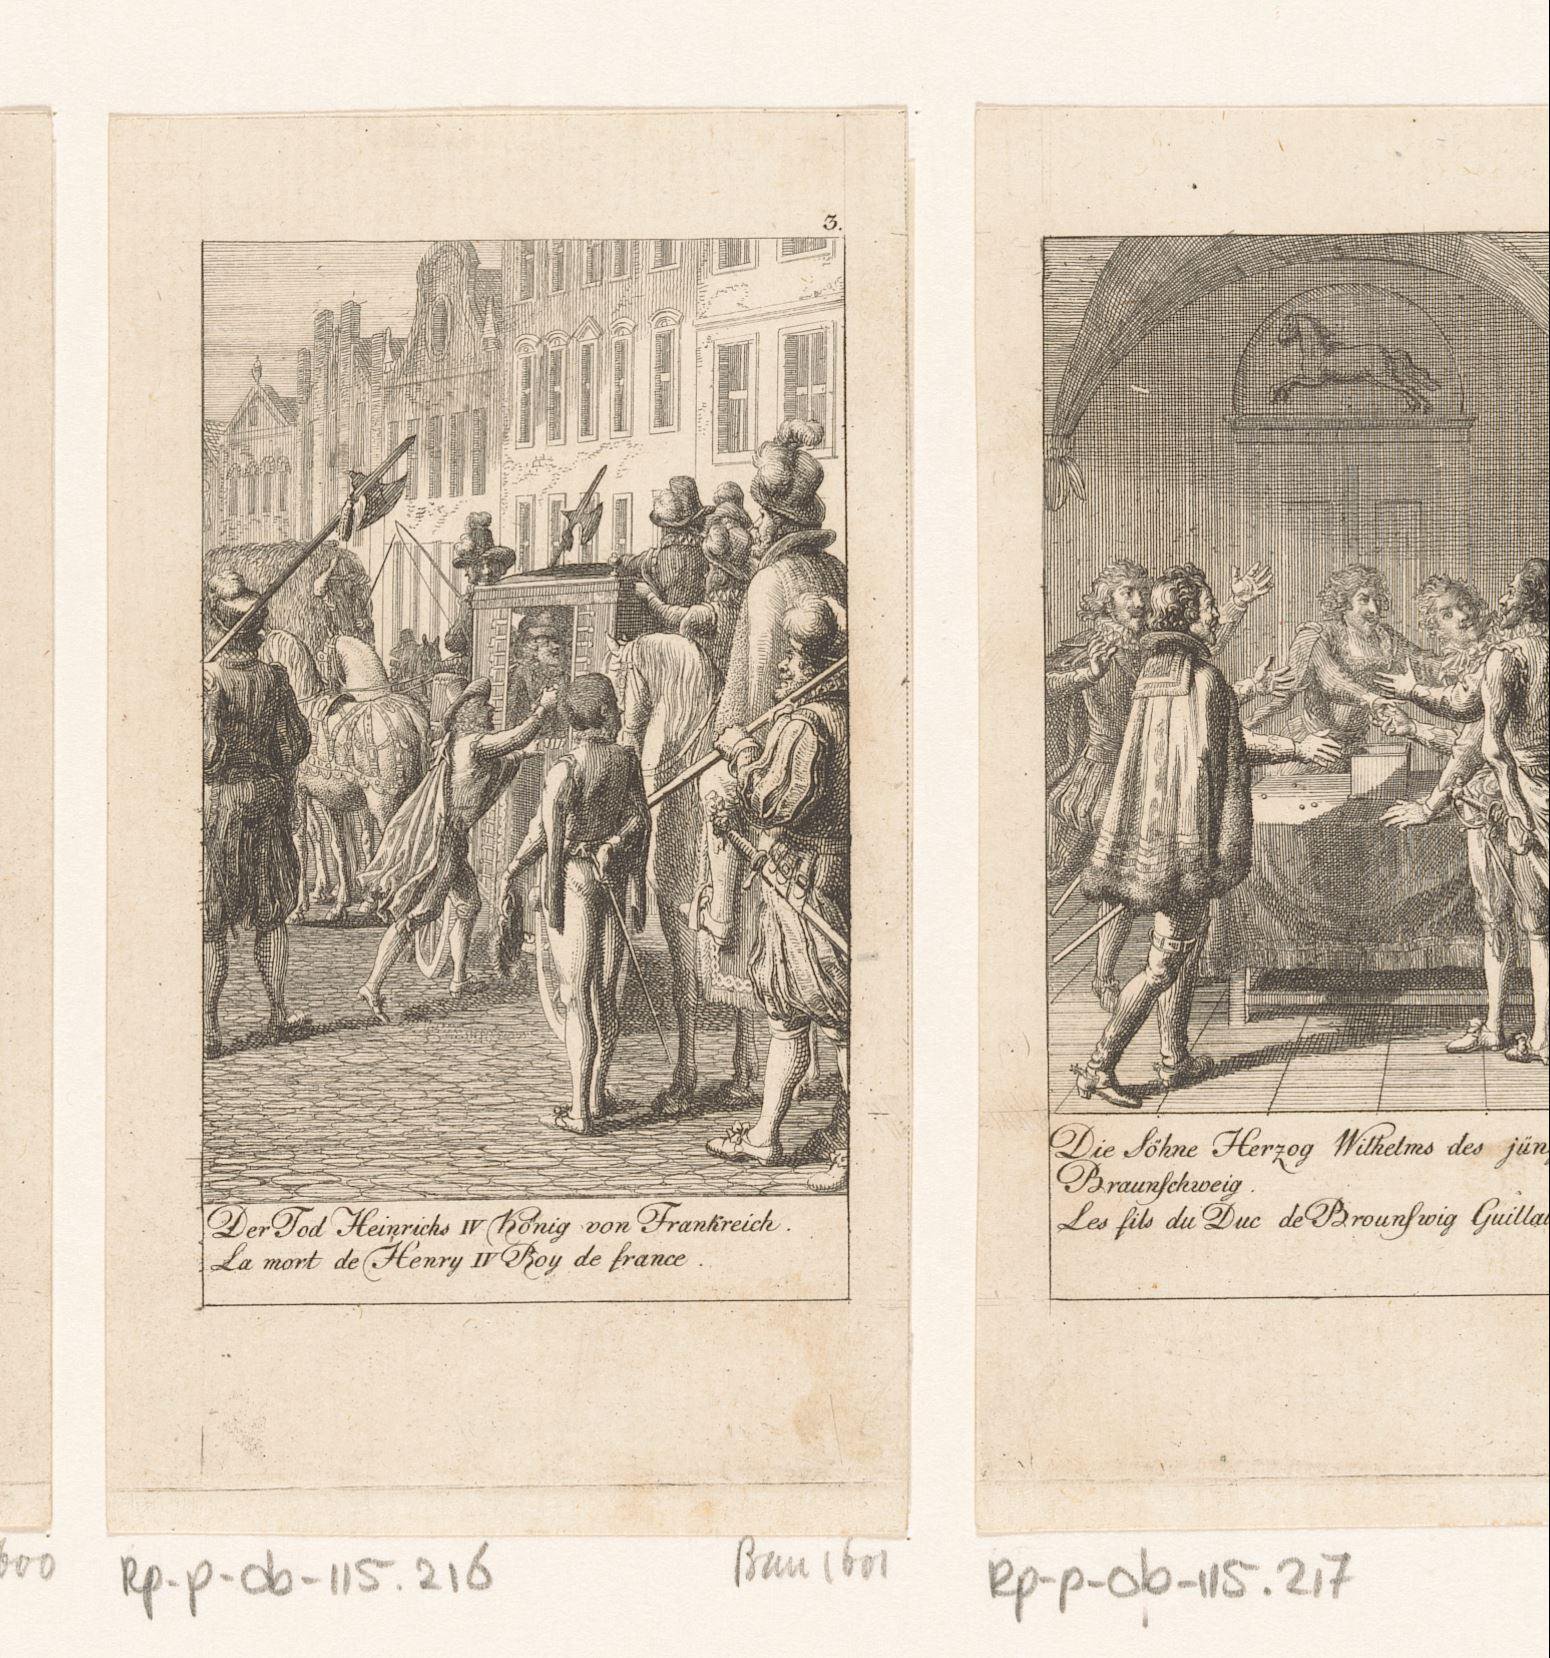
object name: print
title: Hendrik IV van Frankrijk wordt vermoord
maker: daniel nikolaus chodowiecki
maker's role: draughtsman, print maker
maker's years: 1726-1801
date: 1792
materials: paper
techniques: etching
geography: berlin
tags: paris, hendrik iv (koning van frankrijk en navarra), history, murder, ruler, sovereign, surprise attack (from ambush)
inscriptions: collector's mark: Lugt 2228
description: Latere staat gebruikt voor: Almanac de Gotha pour l'anneé 1793. Gotha: C. W. Ettinger, [1792].